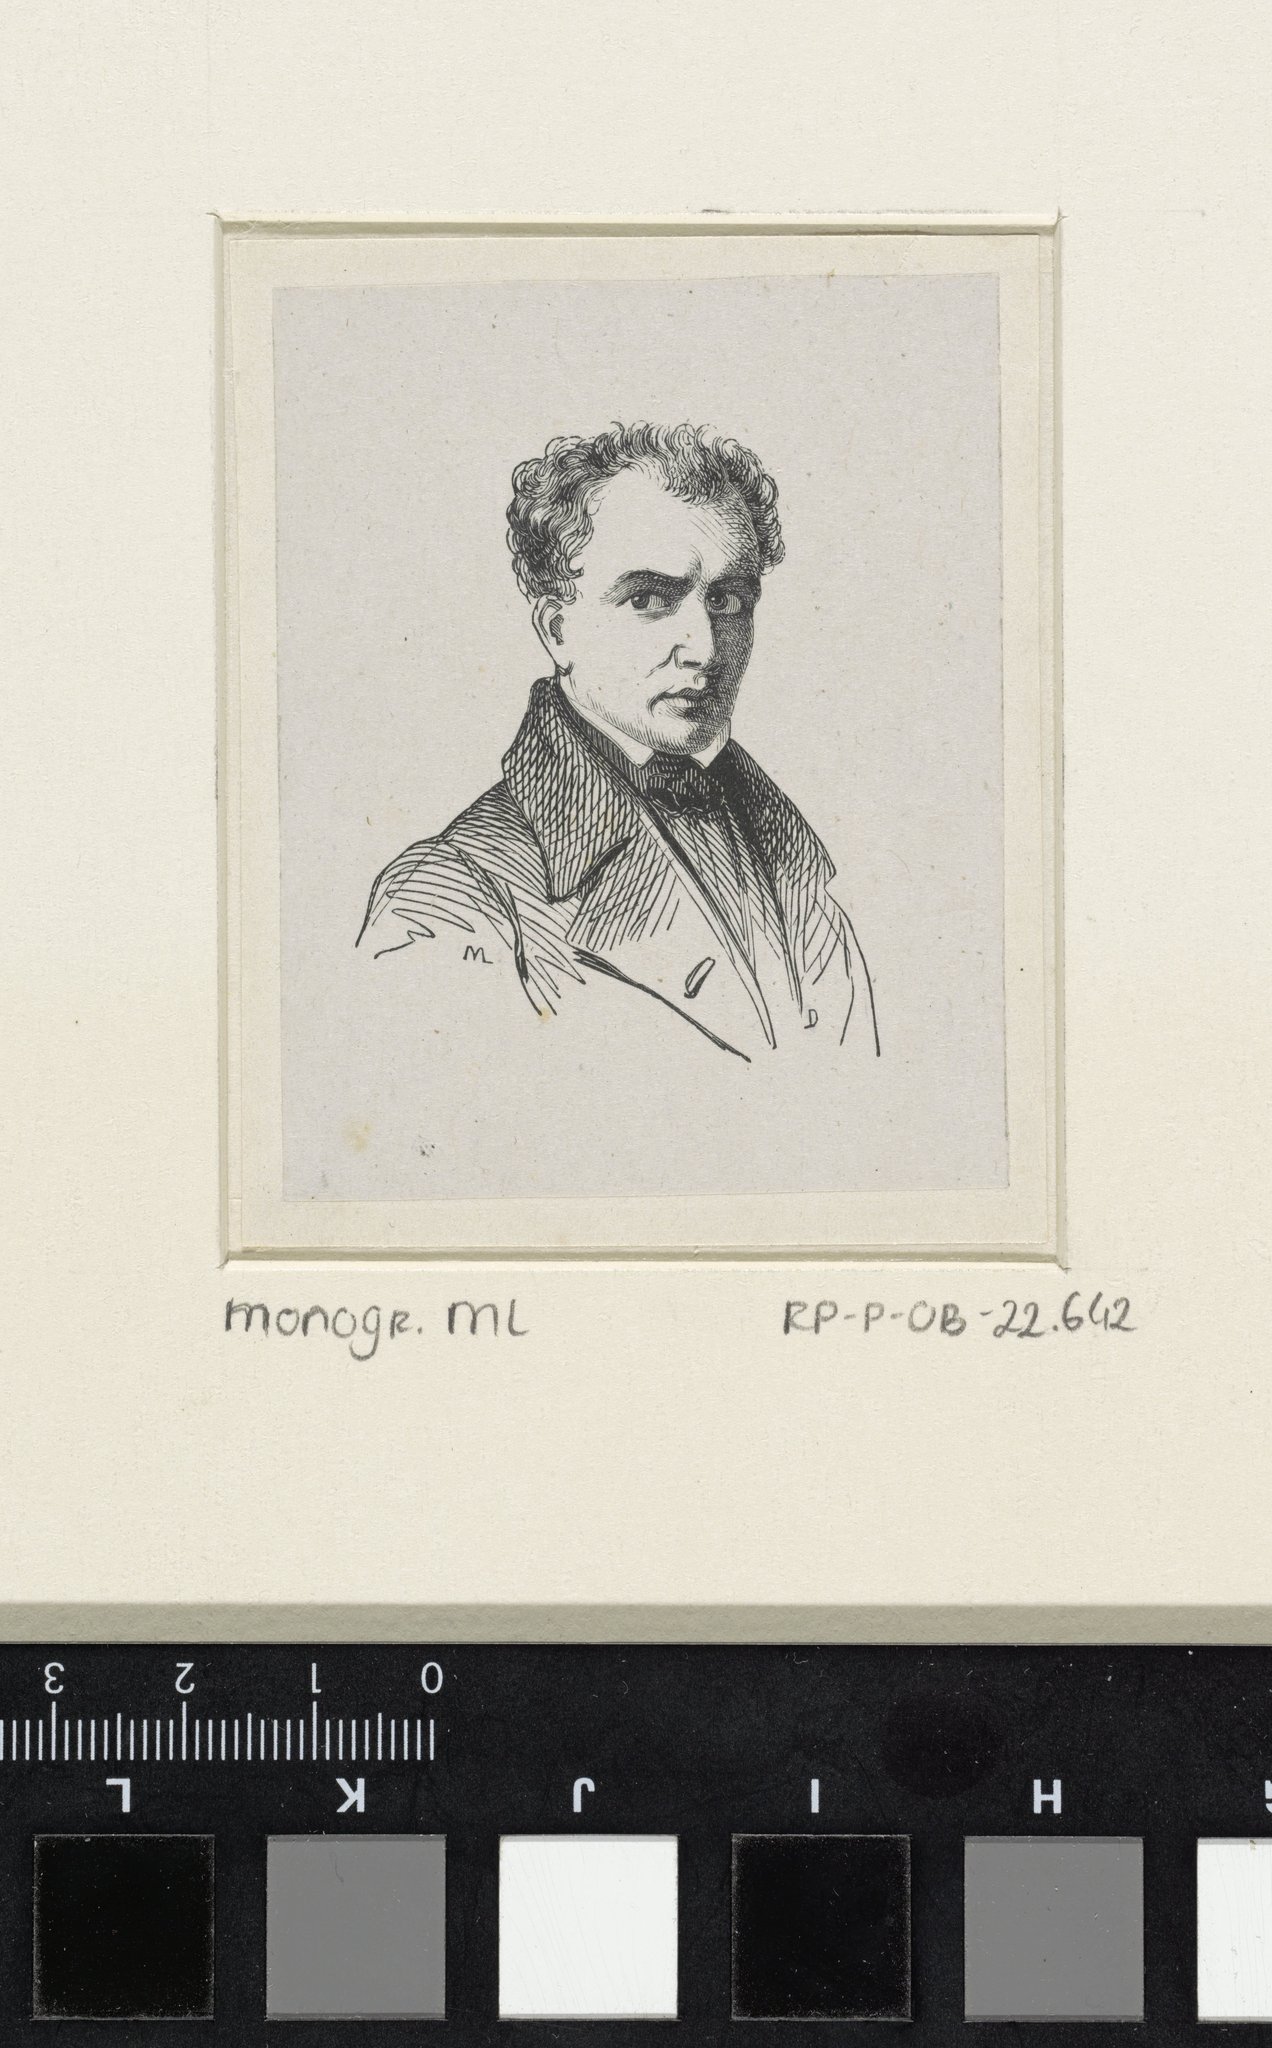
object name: print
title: Portret van François Joseph Navez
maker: monogrammist ml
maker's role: print maker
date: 1800-1900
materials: paper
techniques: engraving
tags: brussels, painter, print maker, draughtsman, françois joseph navez, historical persons, portrait, self-portrait of artist